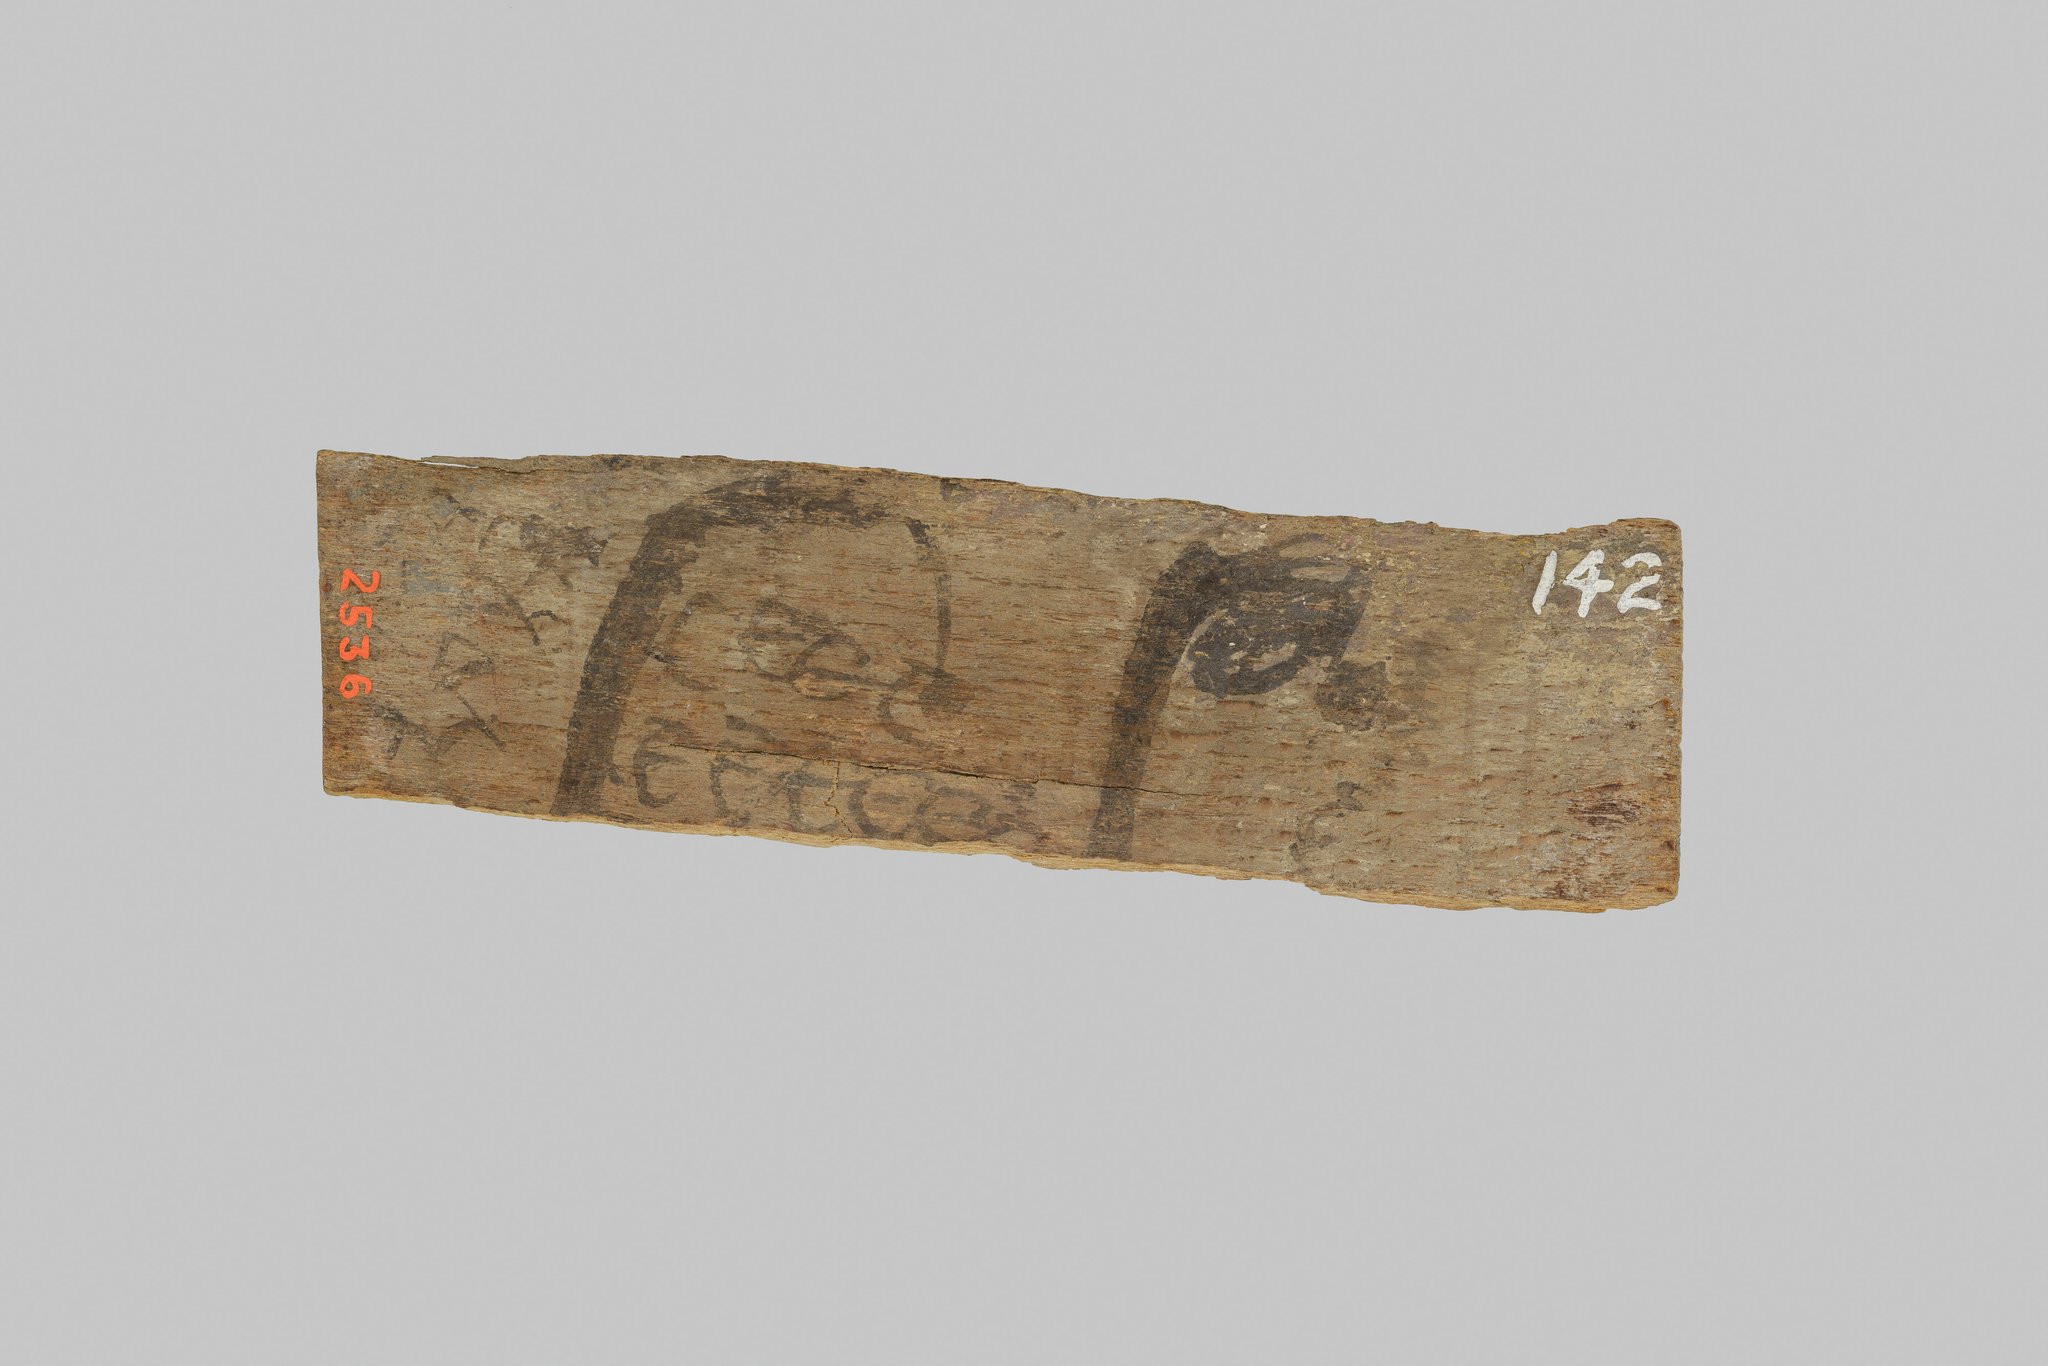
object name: mummy label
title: Fragment of a mummy label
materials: ink, wood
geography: egypt